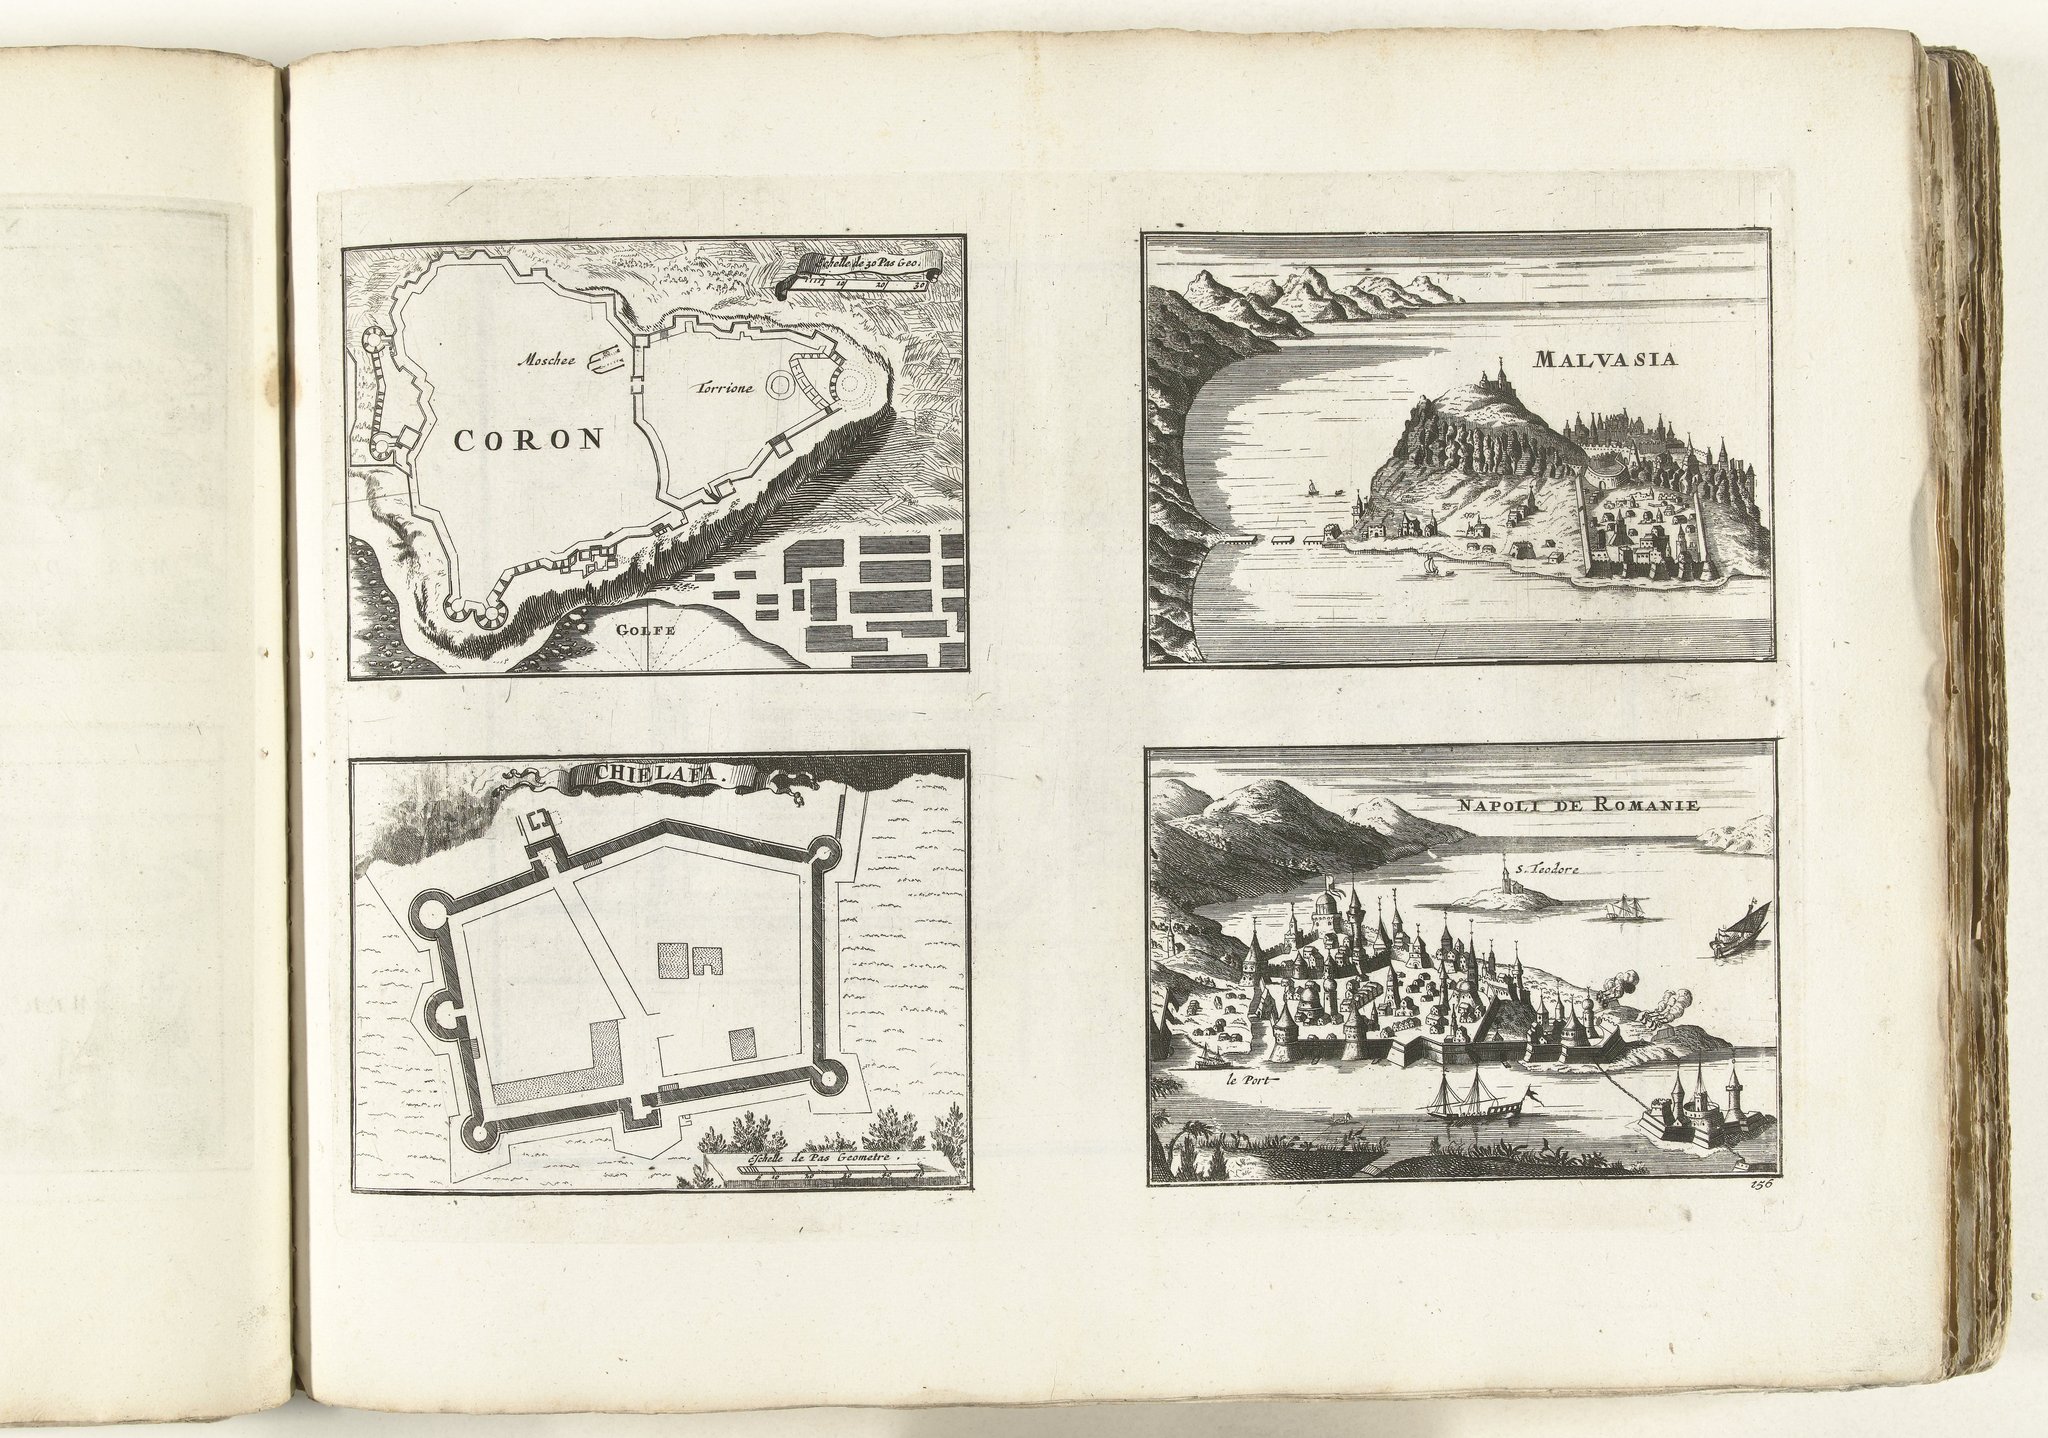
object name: map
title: Les Forces de l'Europe, Asie, Afrique et Amerique, ou description des principales villes avec leurs fortifications. Dessignées par les meilleurs ingenieurs, particulierement celles qui sont sous la domination de la France (...) et ornées de plusieurs superbes edifices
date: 1702-1703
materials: paper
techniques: etching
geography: northern netherlands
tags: fortress, maps of cities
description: Blad met twee plattegronden en twee gezichten op de Griekse steden en forten Coron, Monemvasía (Malvasia), Chielafa en Nafplion (Napoli de Romanie). Plaat nr. 156 in het prentwerk bestaande in totaal uit 276 genummerde platen van vermaarde sterke steden en vestingen in het kader van de Spaanse Successieoorlog. Voor het merendeel zijn deze platen gekopieerd naar de anonieme Franse platen: in Les forces de l'Europe en in: Le theatre de la guerre, dans les Pays-Bas, beide oorspronkelijk uitgegeven door Nicolas de Fer te Parijs (1693-1697) in het kader van de Negenjarige Oorlog. Titels en opschriften in de plaat in het Frans.